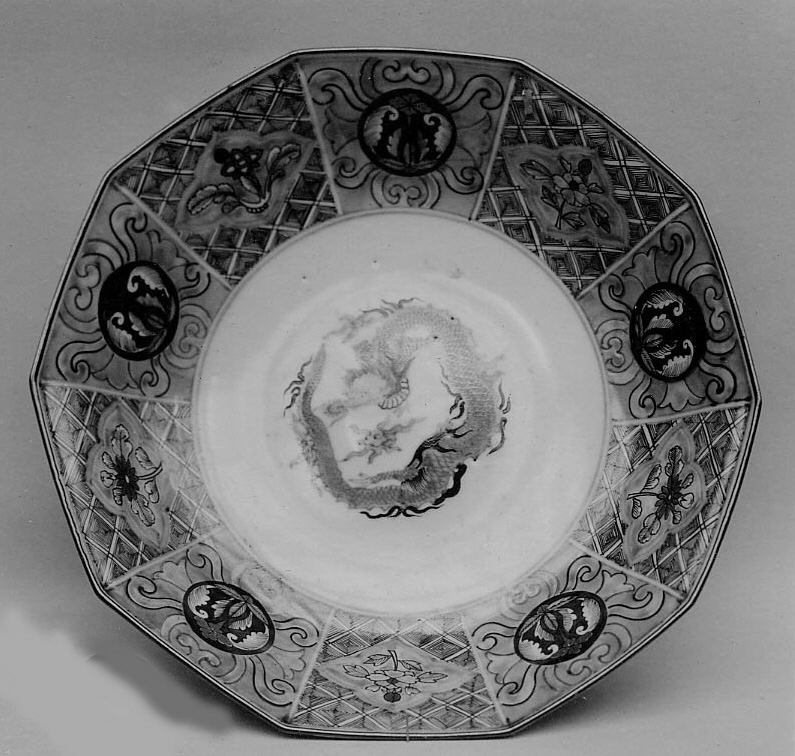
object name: dish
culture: japanese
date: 1840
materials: enamel, porcelain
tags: dragons